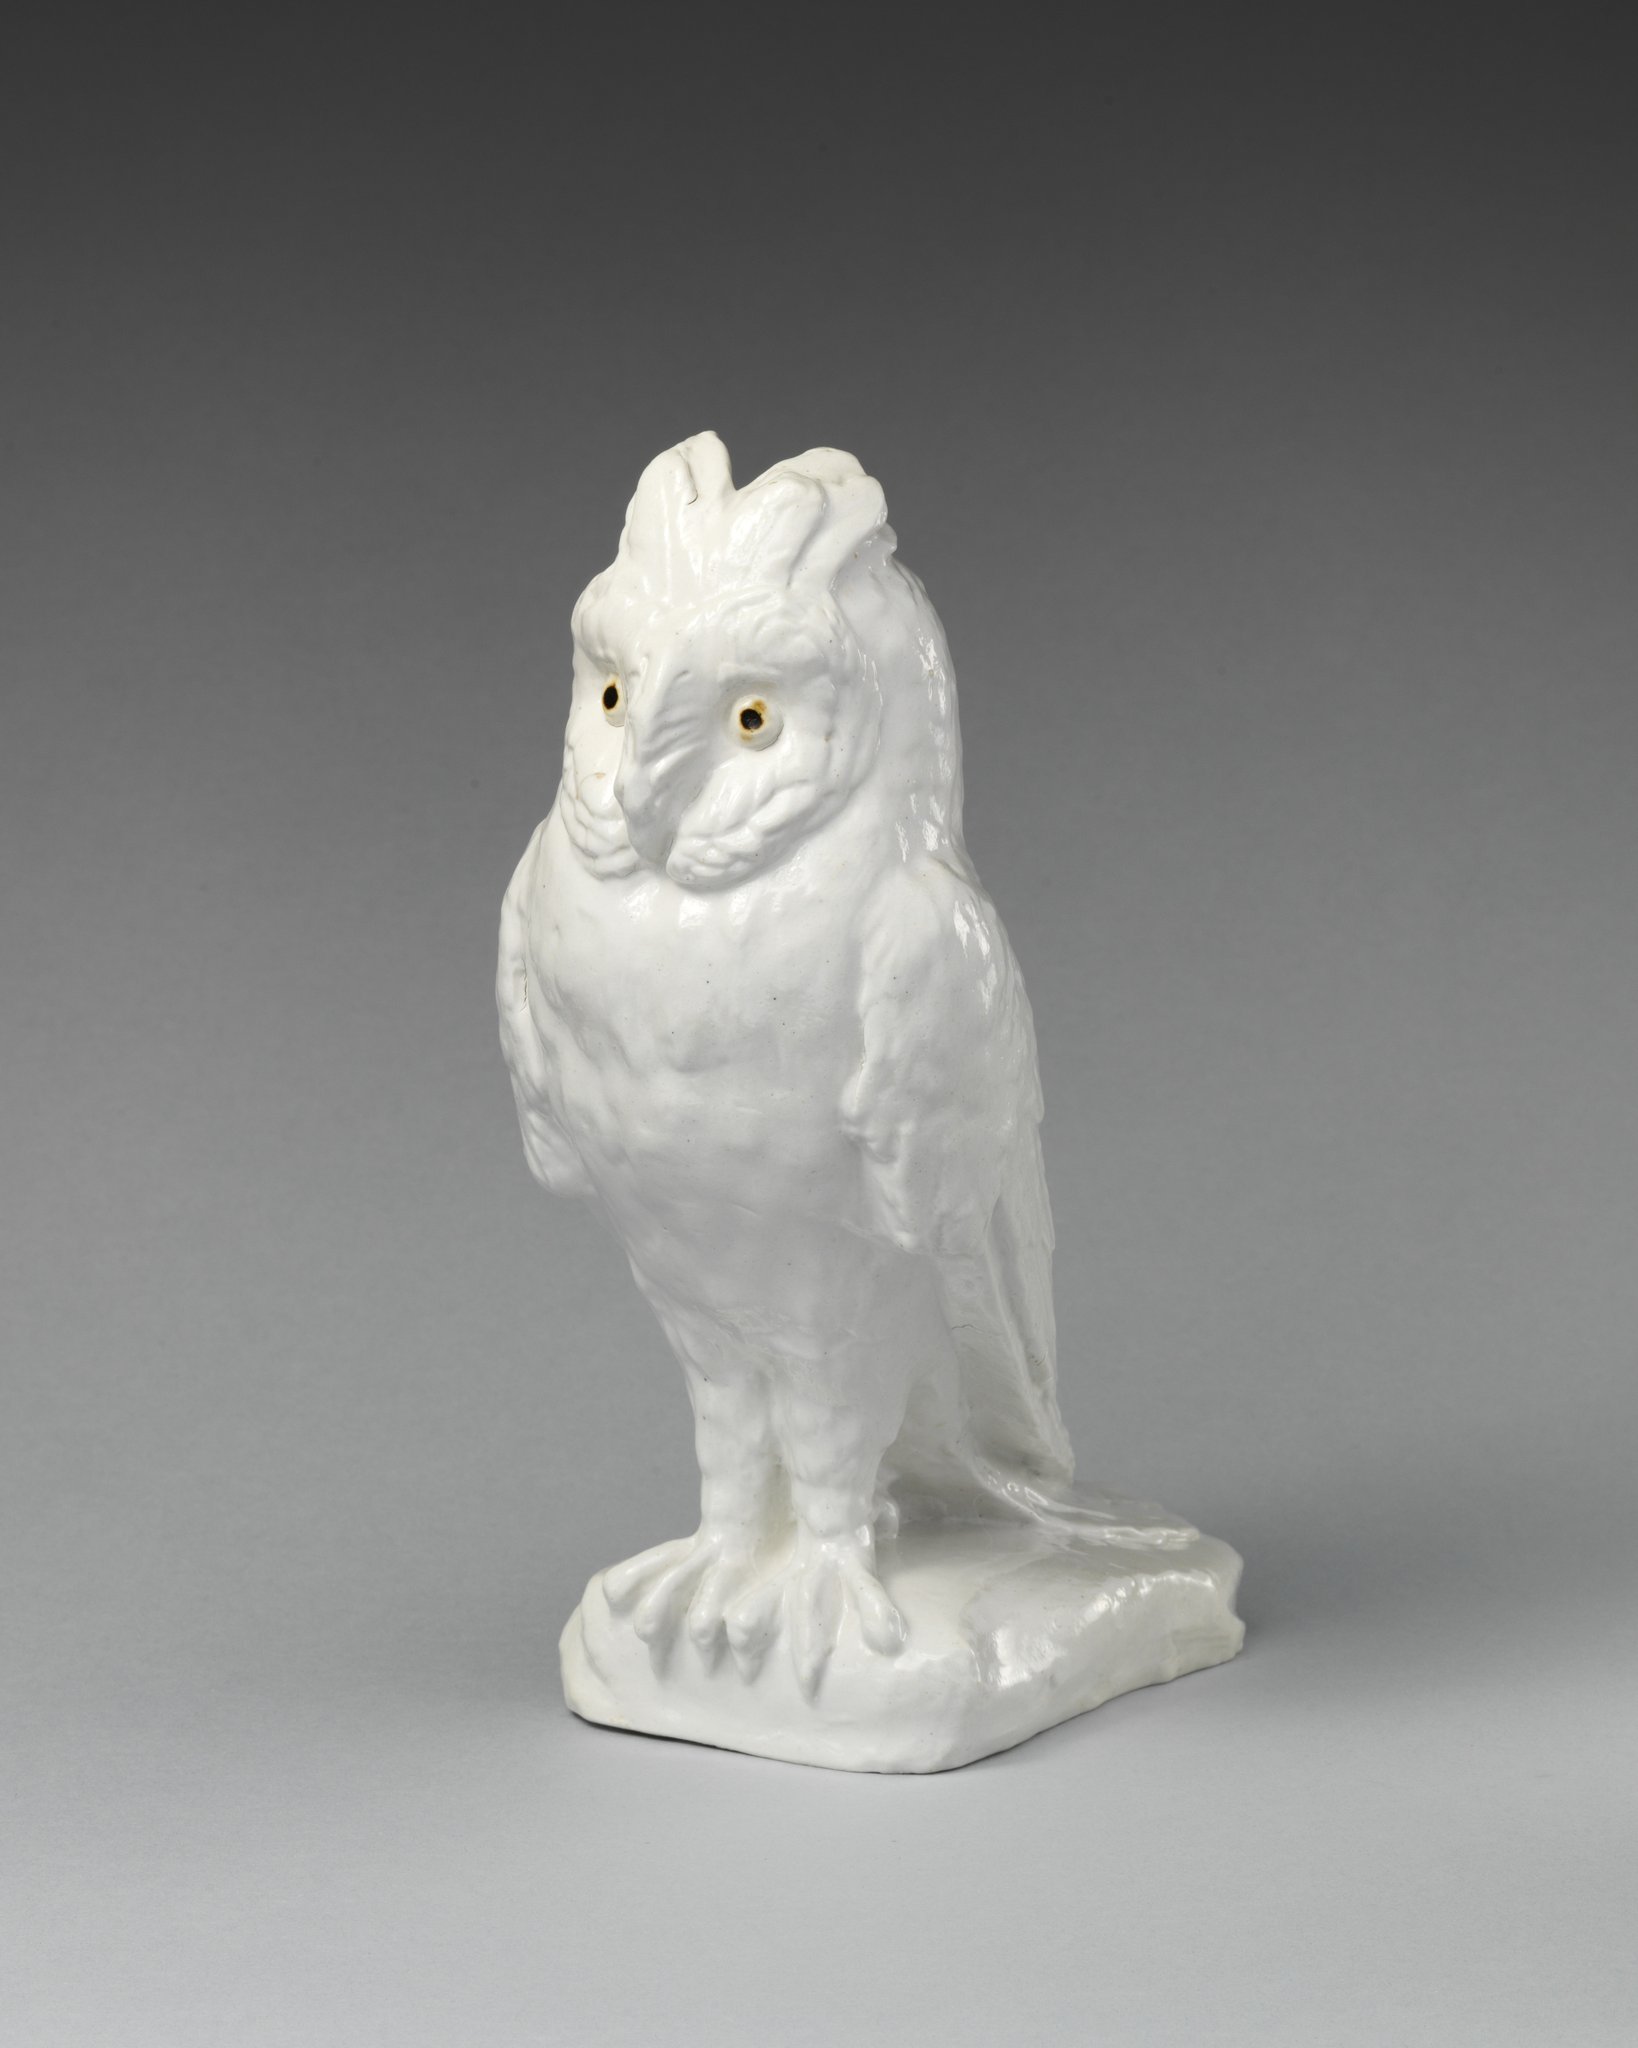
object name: figure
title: Owl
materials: stoneware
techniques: salt glaze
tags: owls